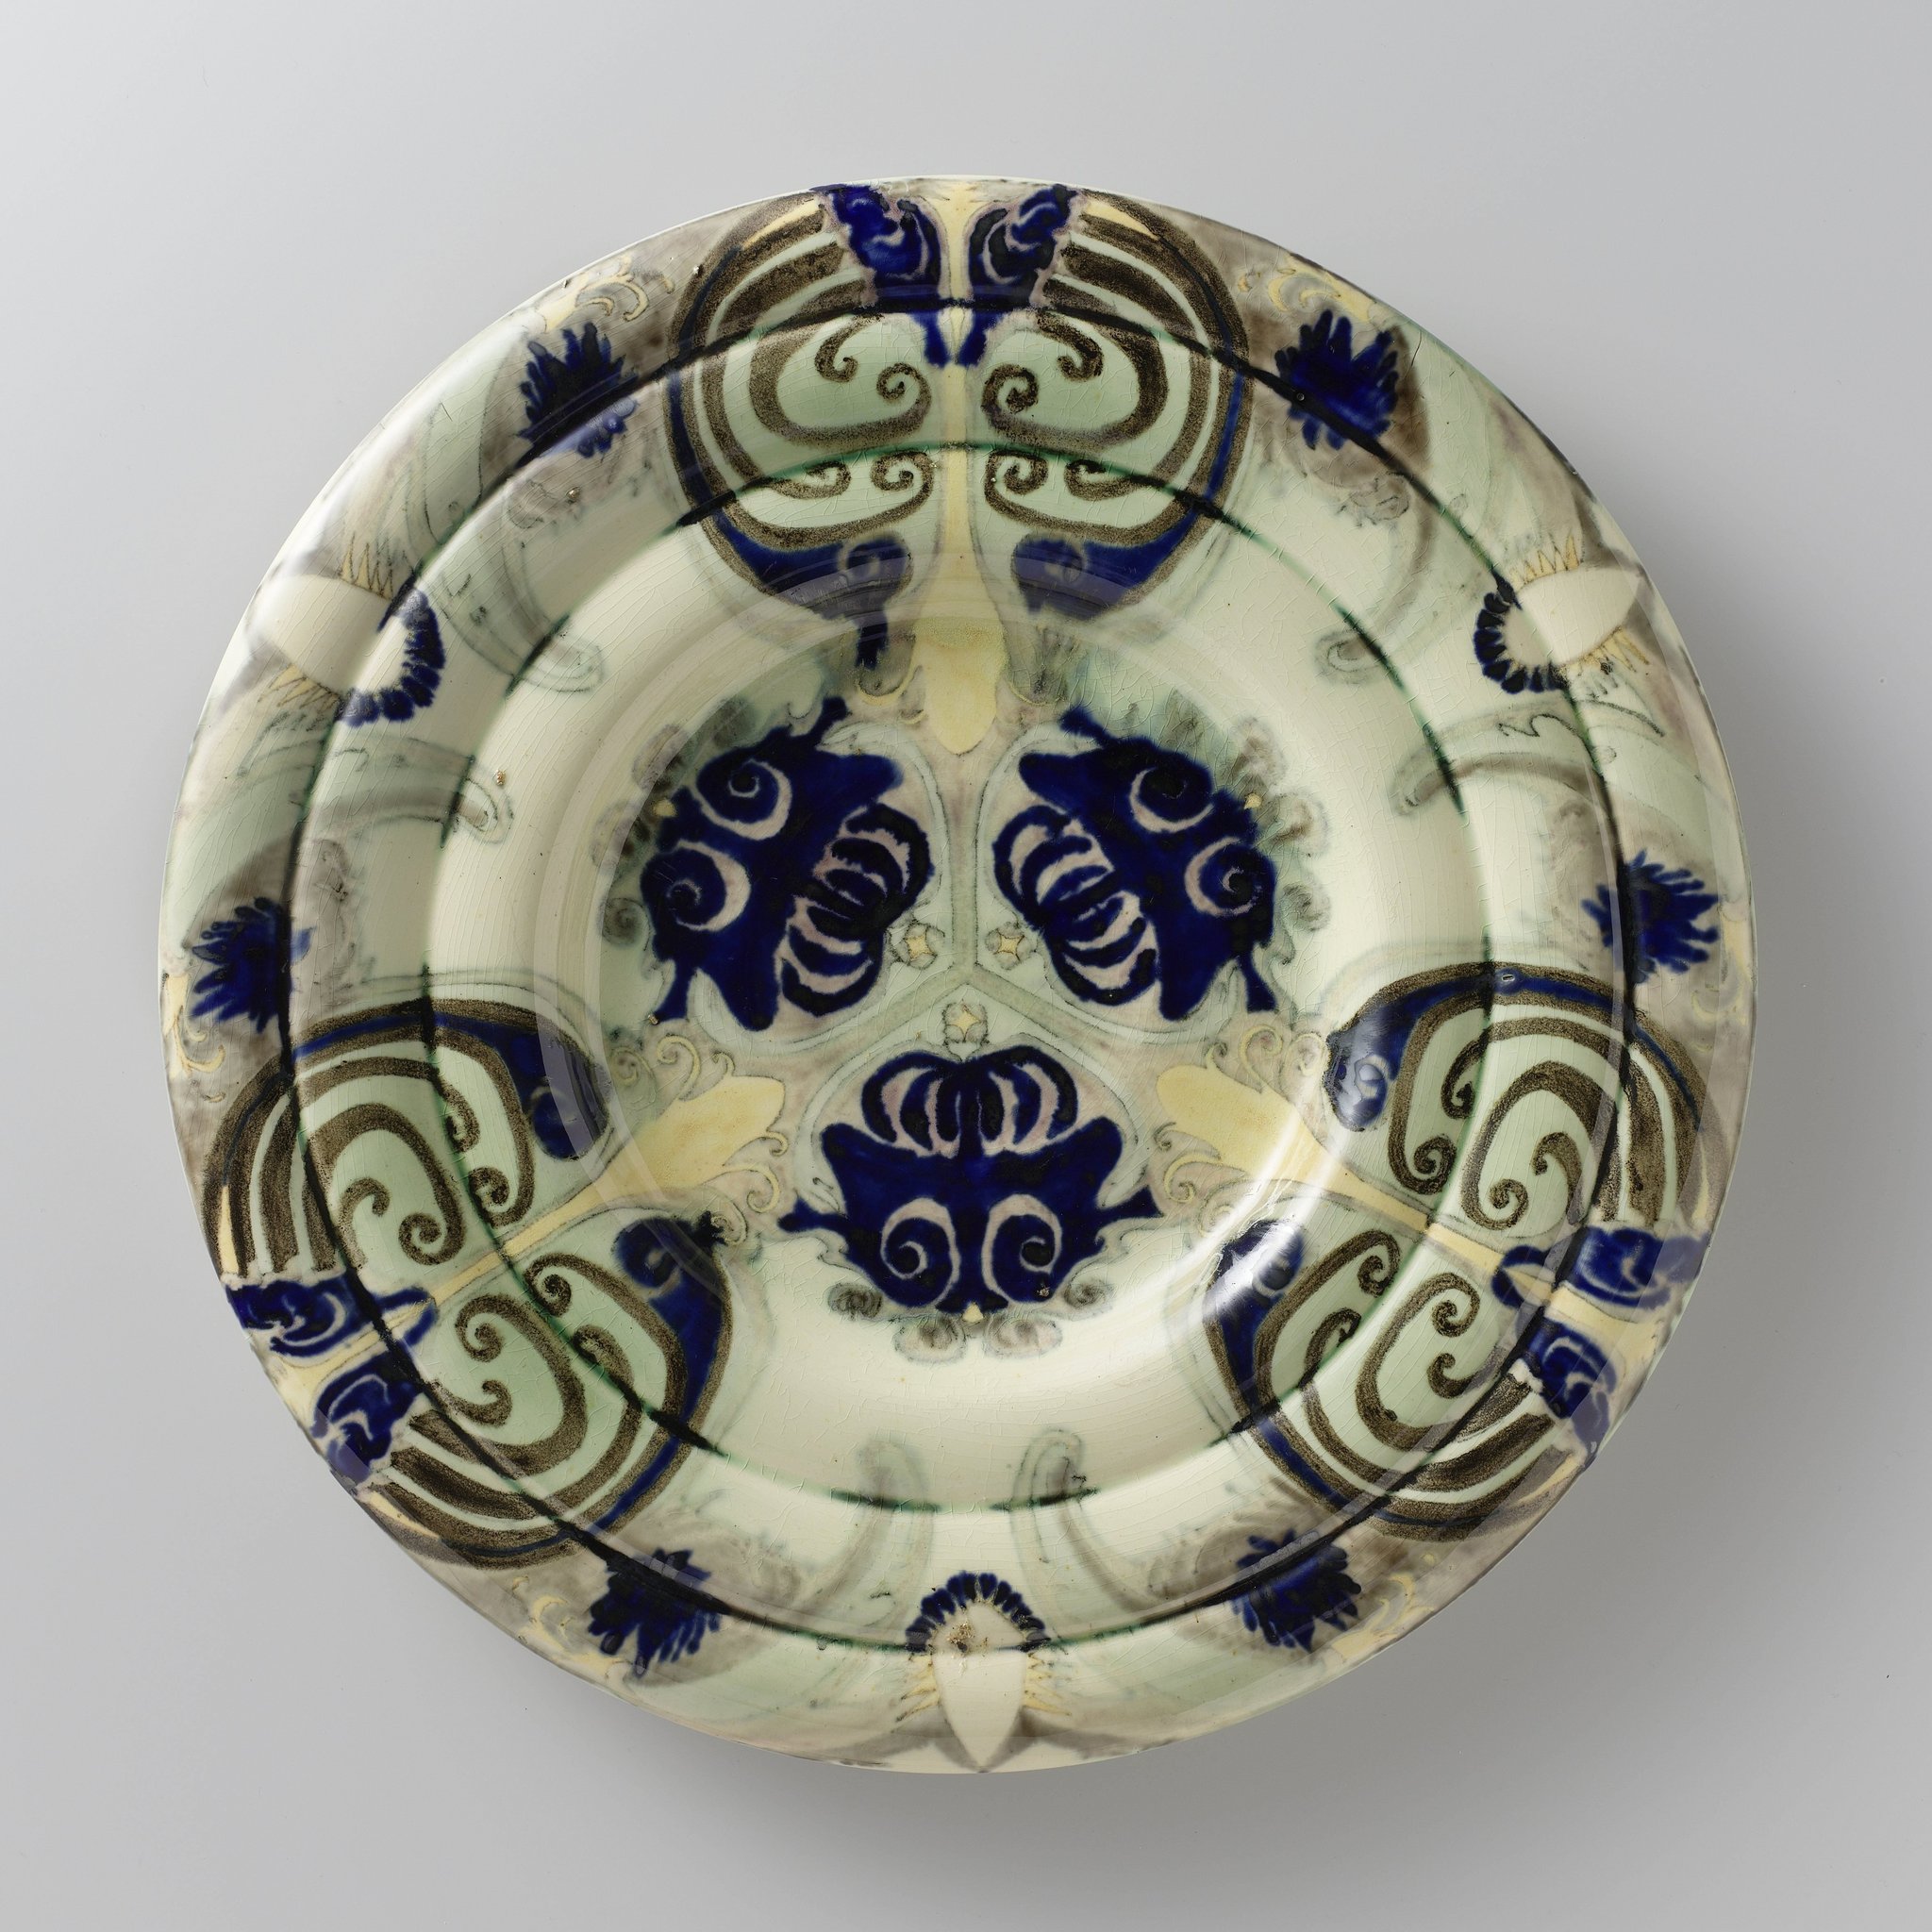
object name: plate dish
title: Wandbord met drie bloemmotieven op het plat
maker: theo colenbrander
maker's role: draughtsman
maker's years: 1841-1930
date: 1888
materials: earthenware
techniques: painted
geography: the hague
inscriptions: mark: ‘W. v met vlag G. / den Haag / D, daaronder: Moite en tevens vier punten, waaronder een horizontale streep (alles in zwart).’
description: Decorative plate. Earthenware. The Hague, Haagsche Plateelbakkerij Rozenburg, 1888, designed by Theodorus A.C. Colenbrander. Factory under the direction of Wilhelm W. von Gudenberg.